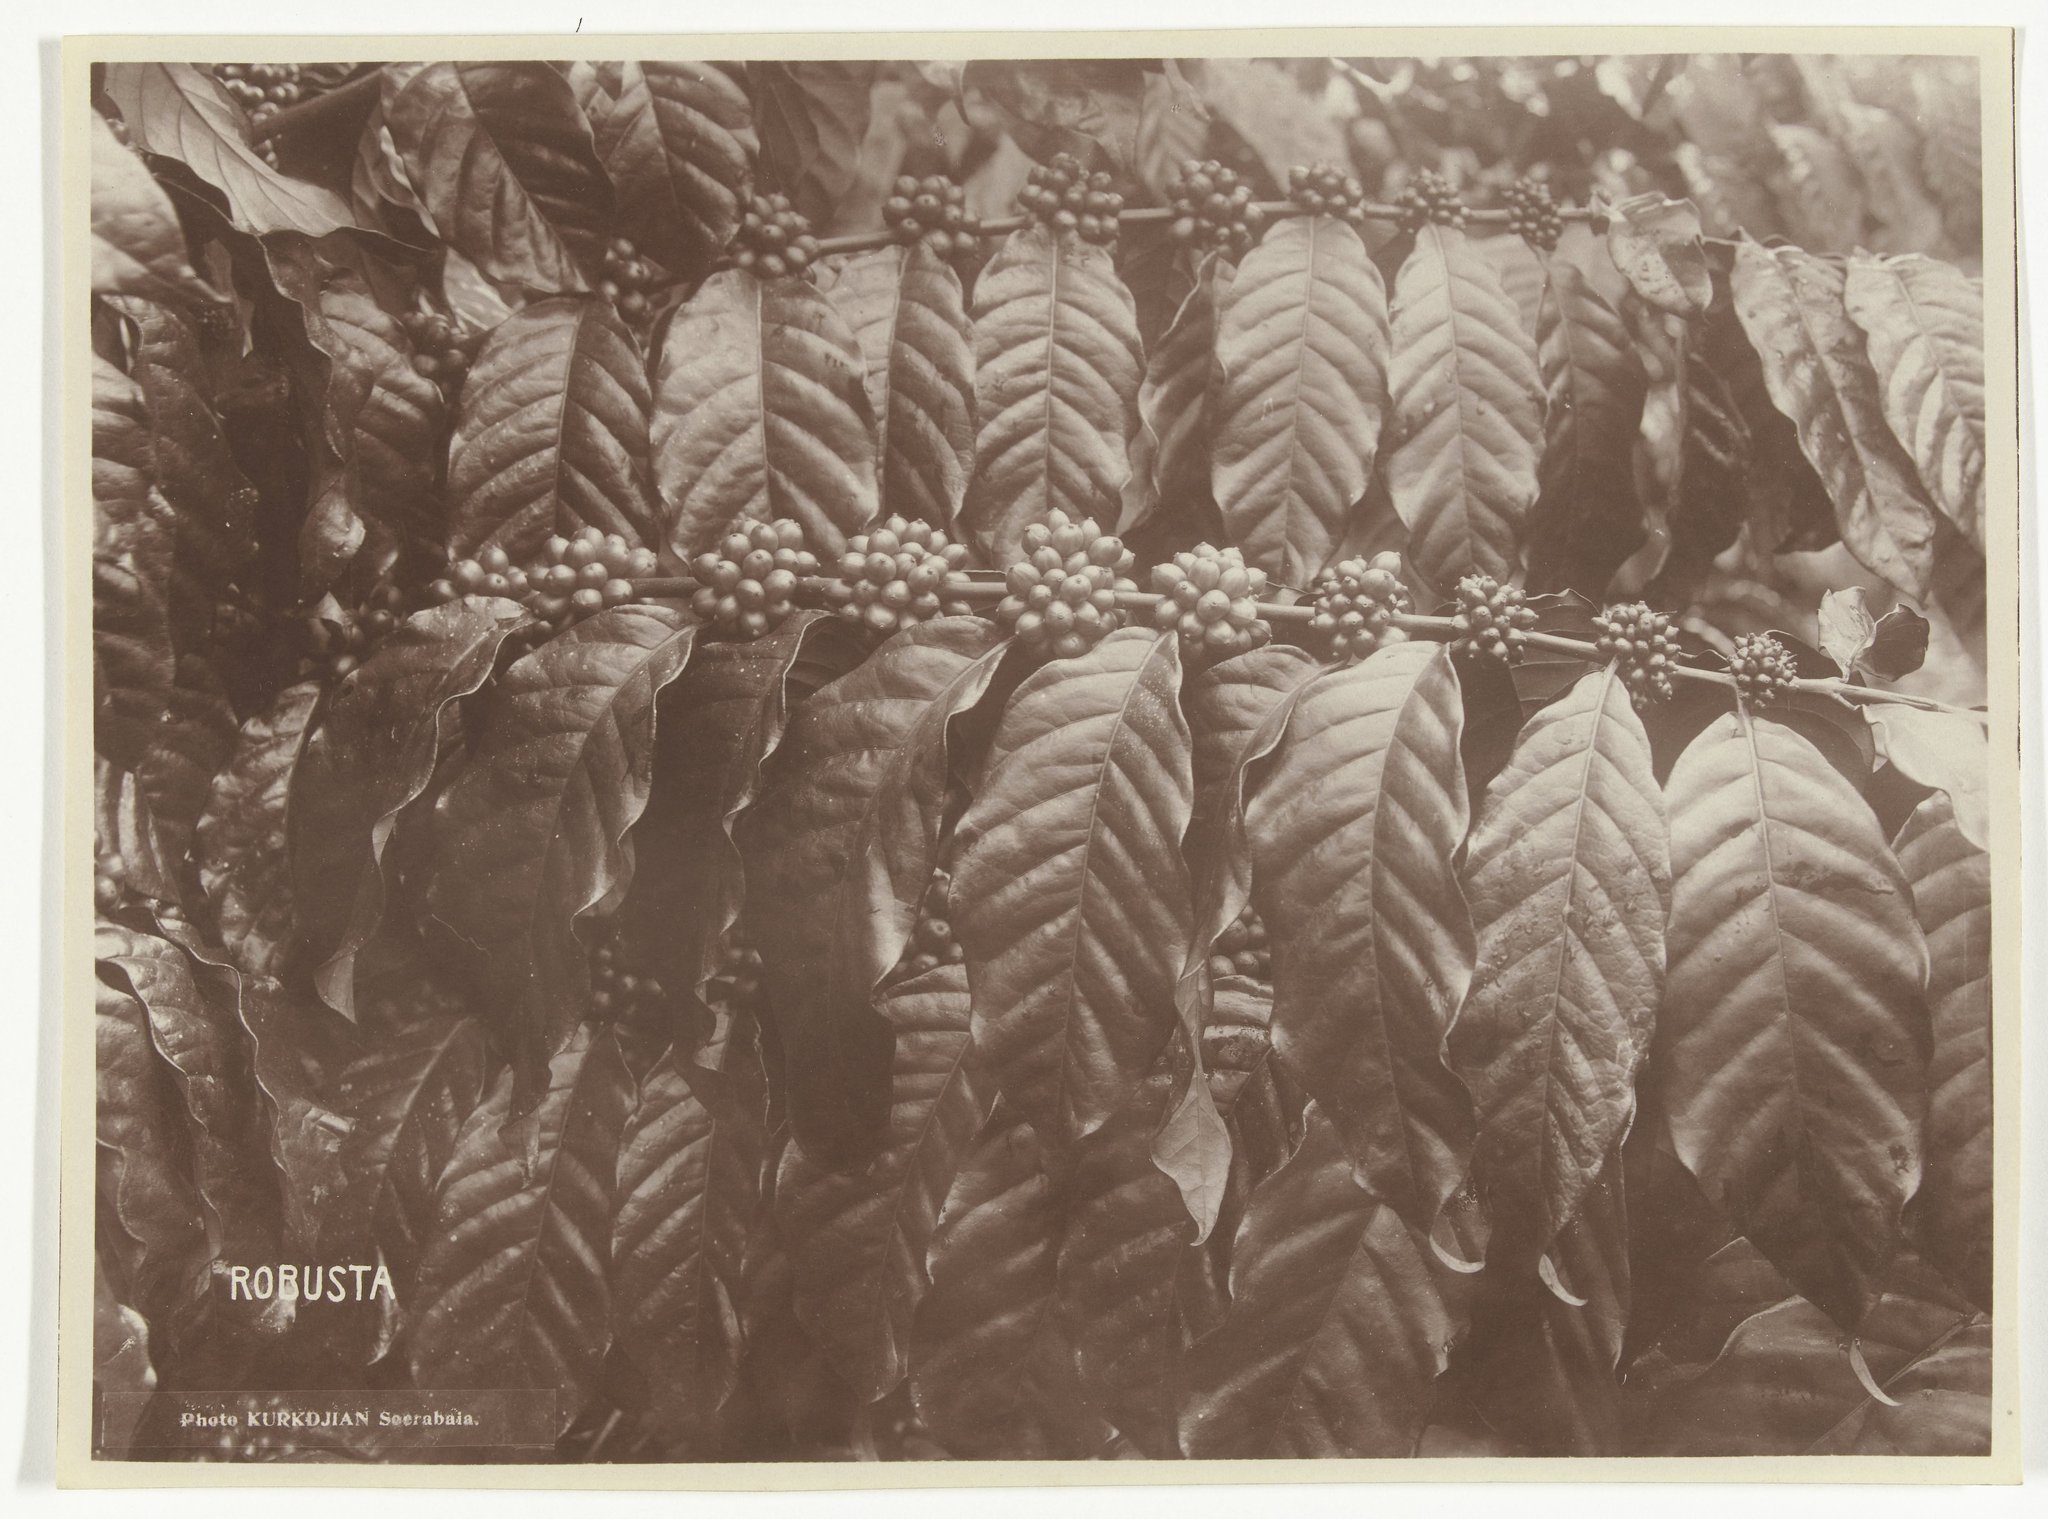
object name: photograph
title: Koffieplant met vruchten (Robusta), voormalig Nederlands-Indië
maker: onnes kurkdjian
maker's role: fotograaf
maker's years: 1851-1903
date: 1890-1935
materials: paper, photographic support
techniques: gelatin silver print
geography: dutch east indies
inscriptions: name: ‘Robusta’, name: ‘Photo Kurkdjian Soerabaia’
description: Koffieplant met vruchten (Robusta), voormalig Nederlands-Indië